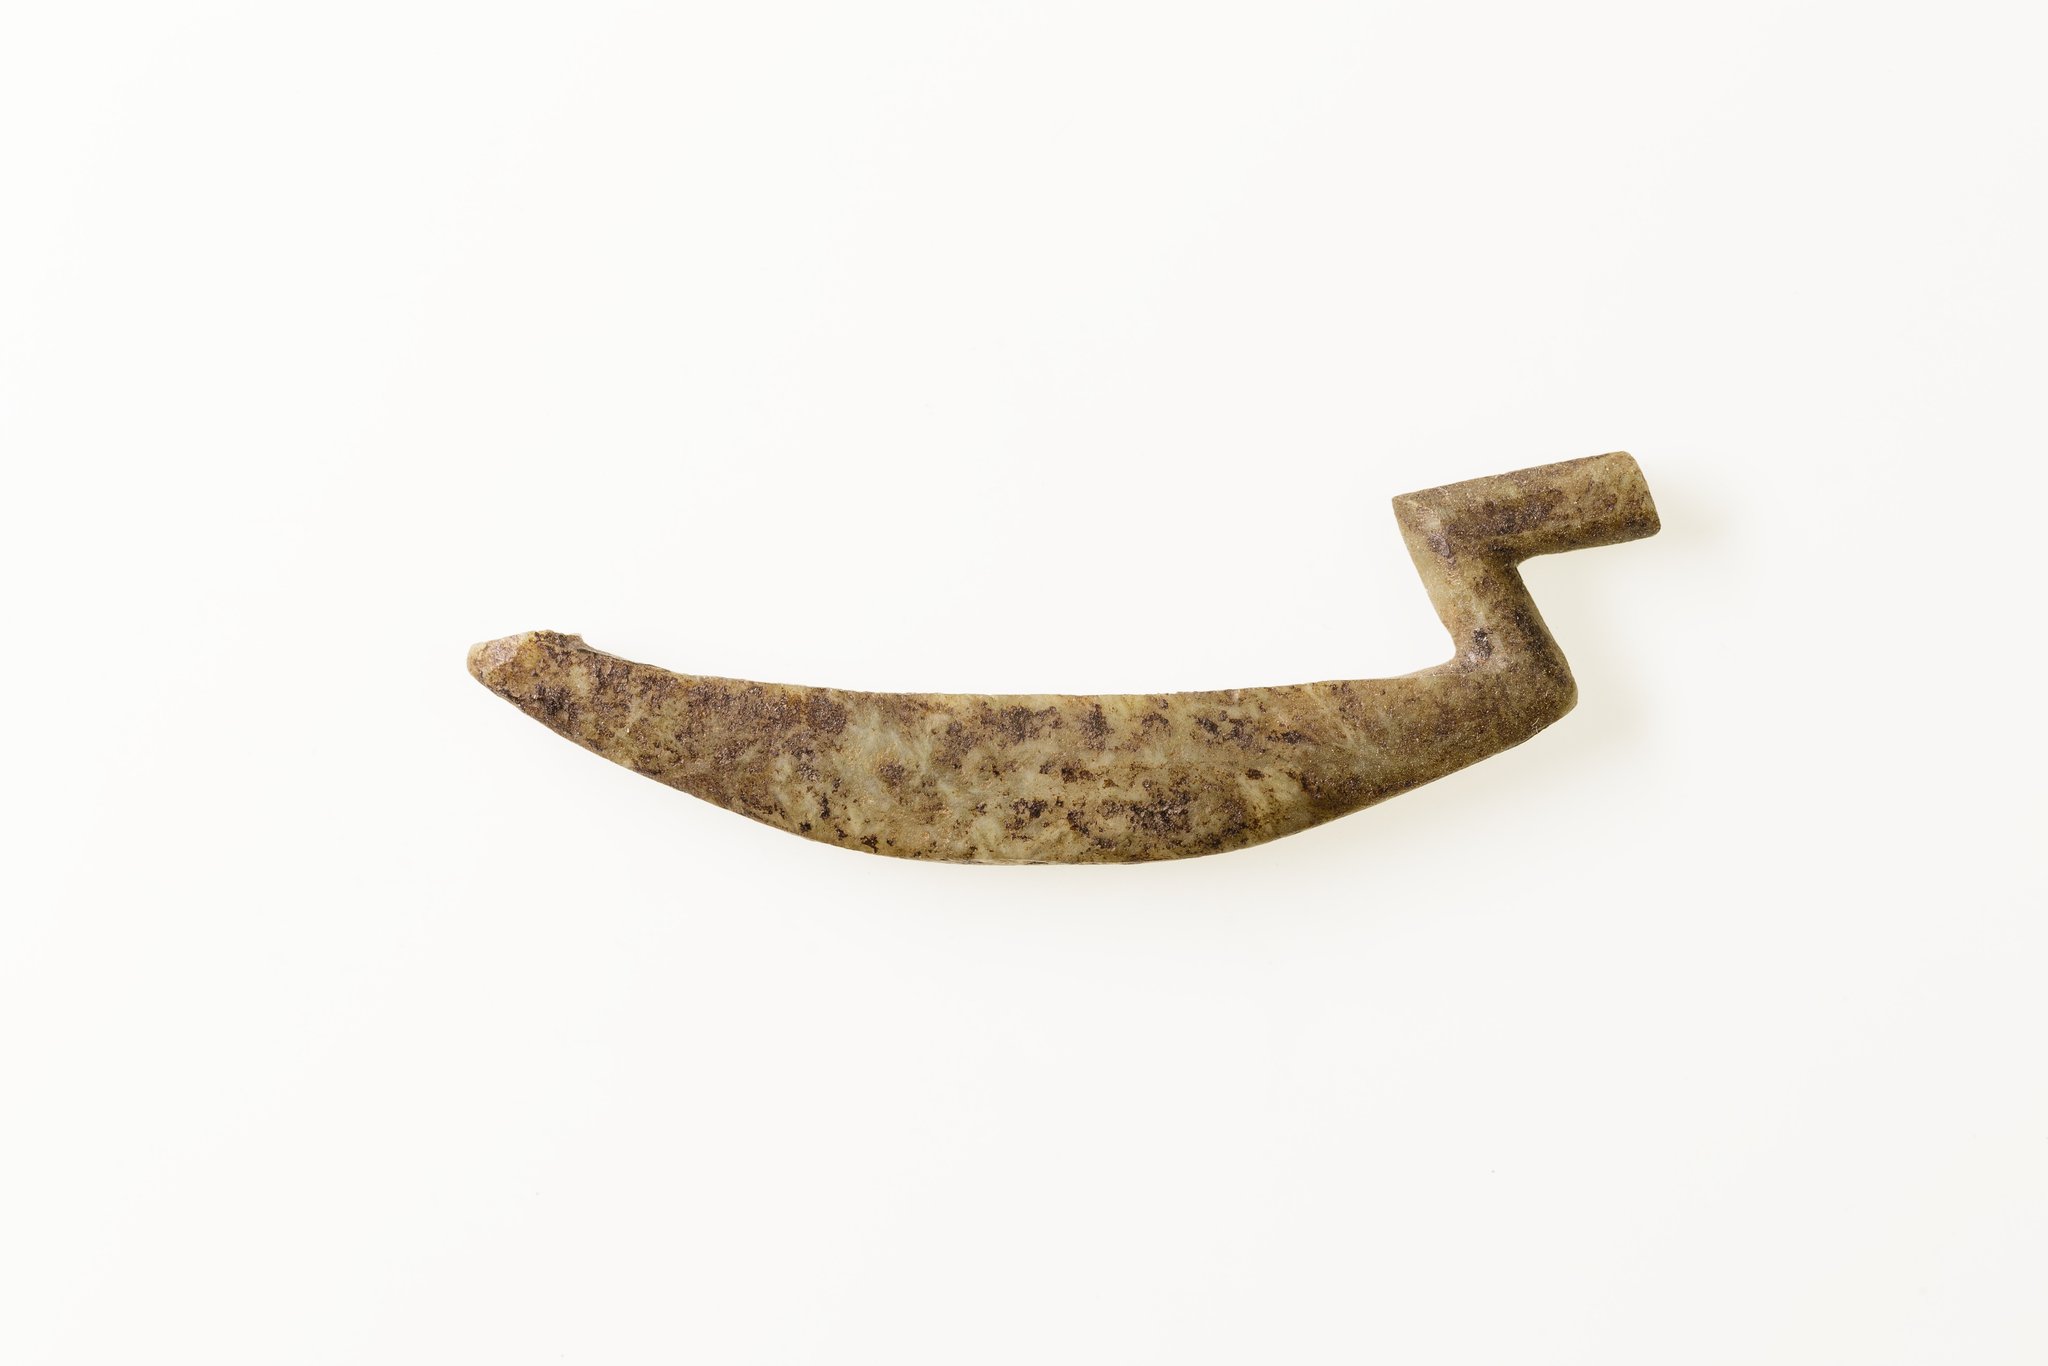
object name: inlay, hieroglyph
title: Boat inlay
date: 522-343 BCE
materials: stone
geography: egypt